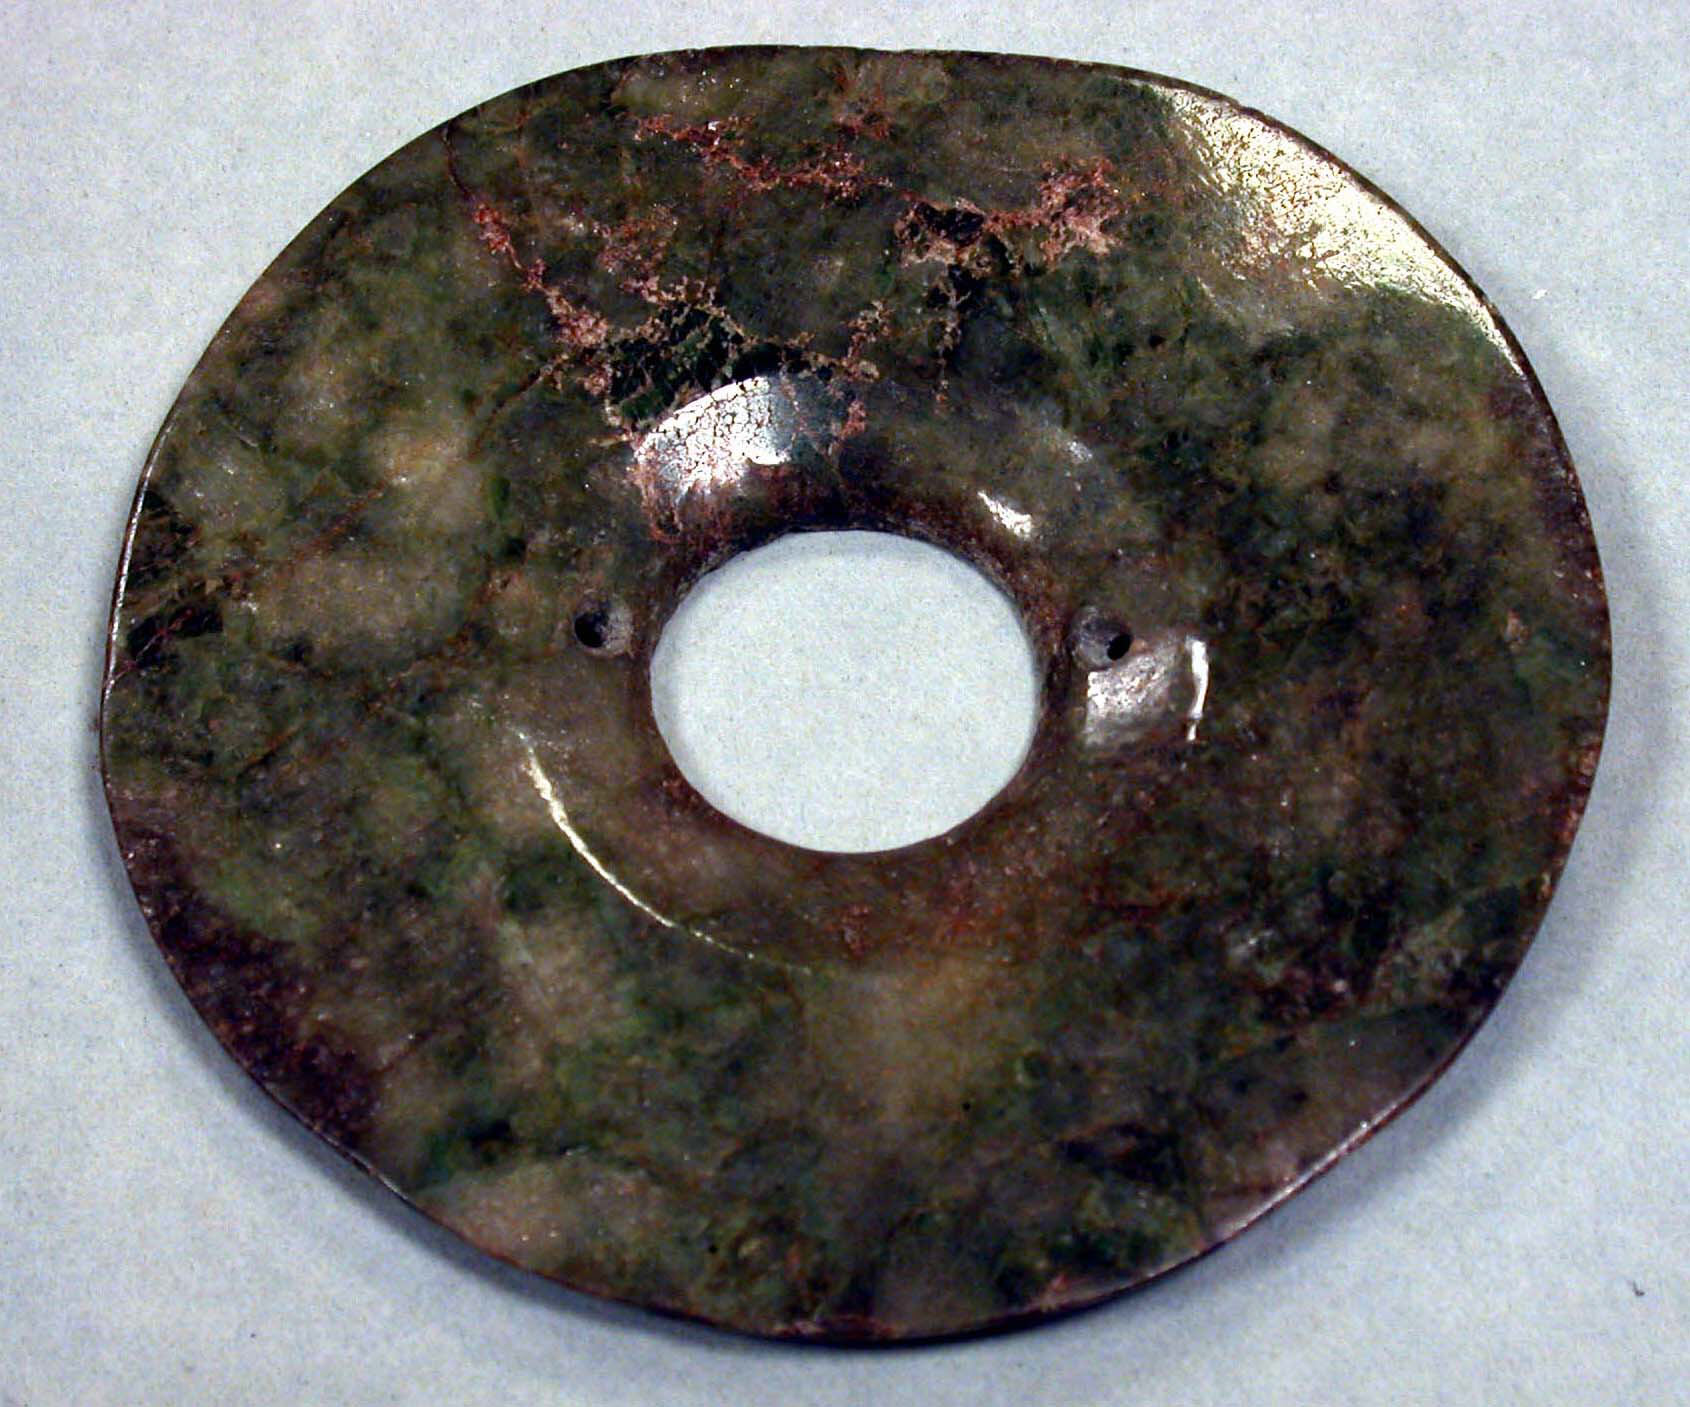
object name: earflare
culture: mexican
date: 1501-1600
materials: stone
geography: mexico